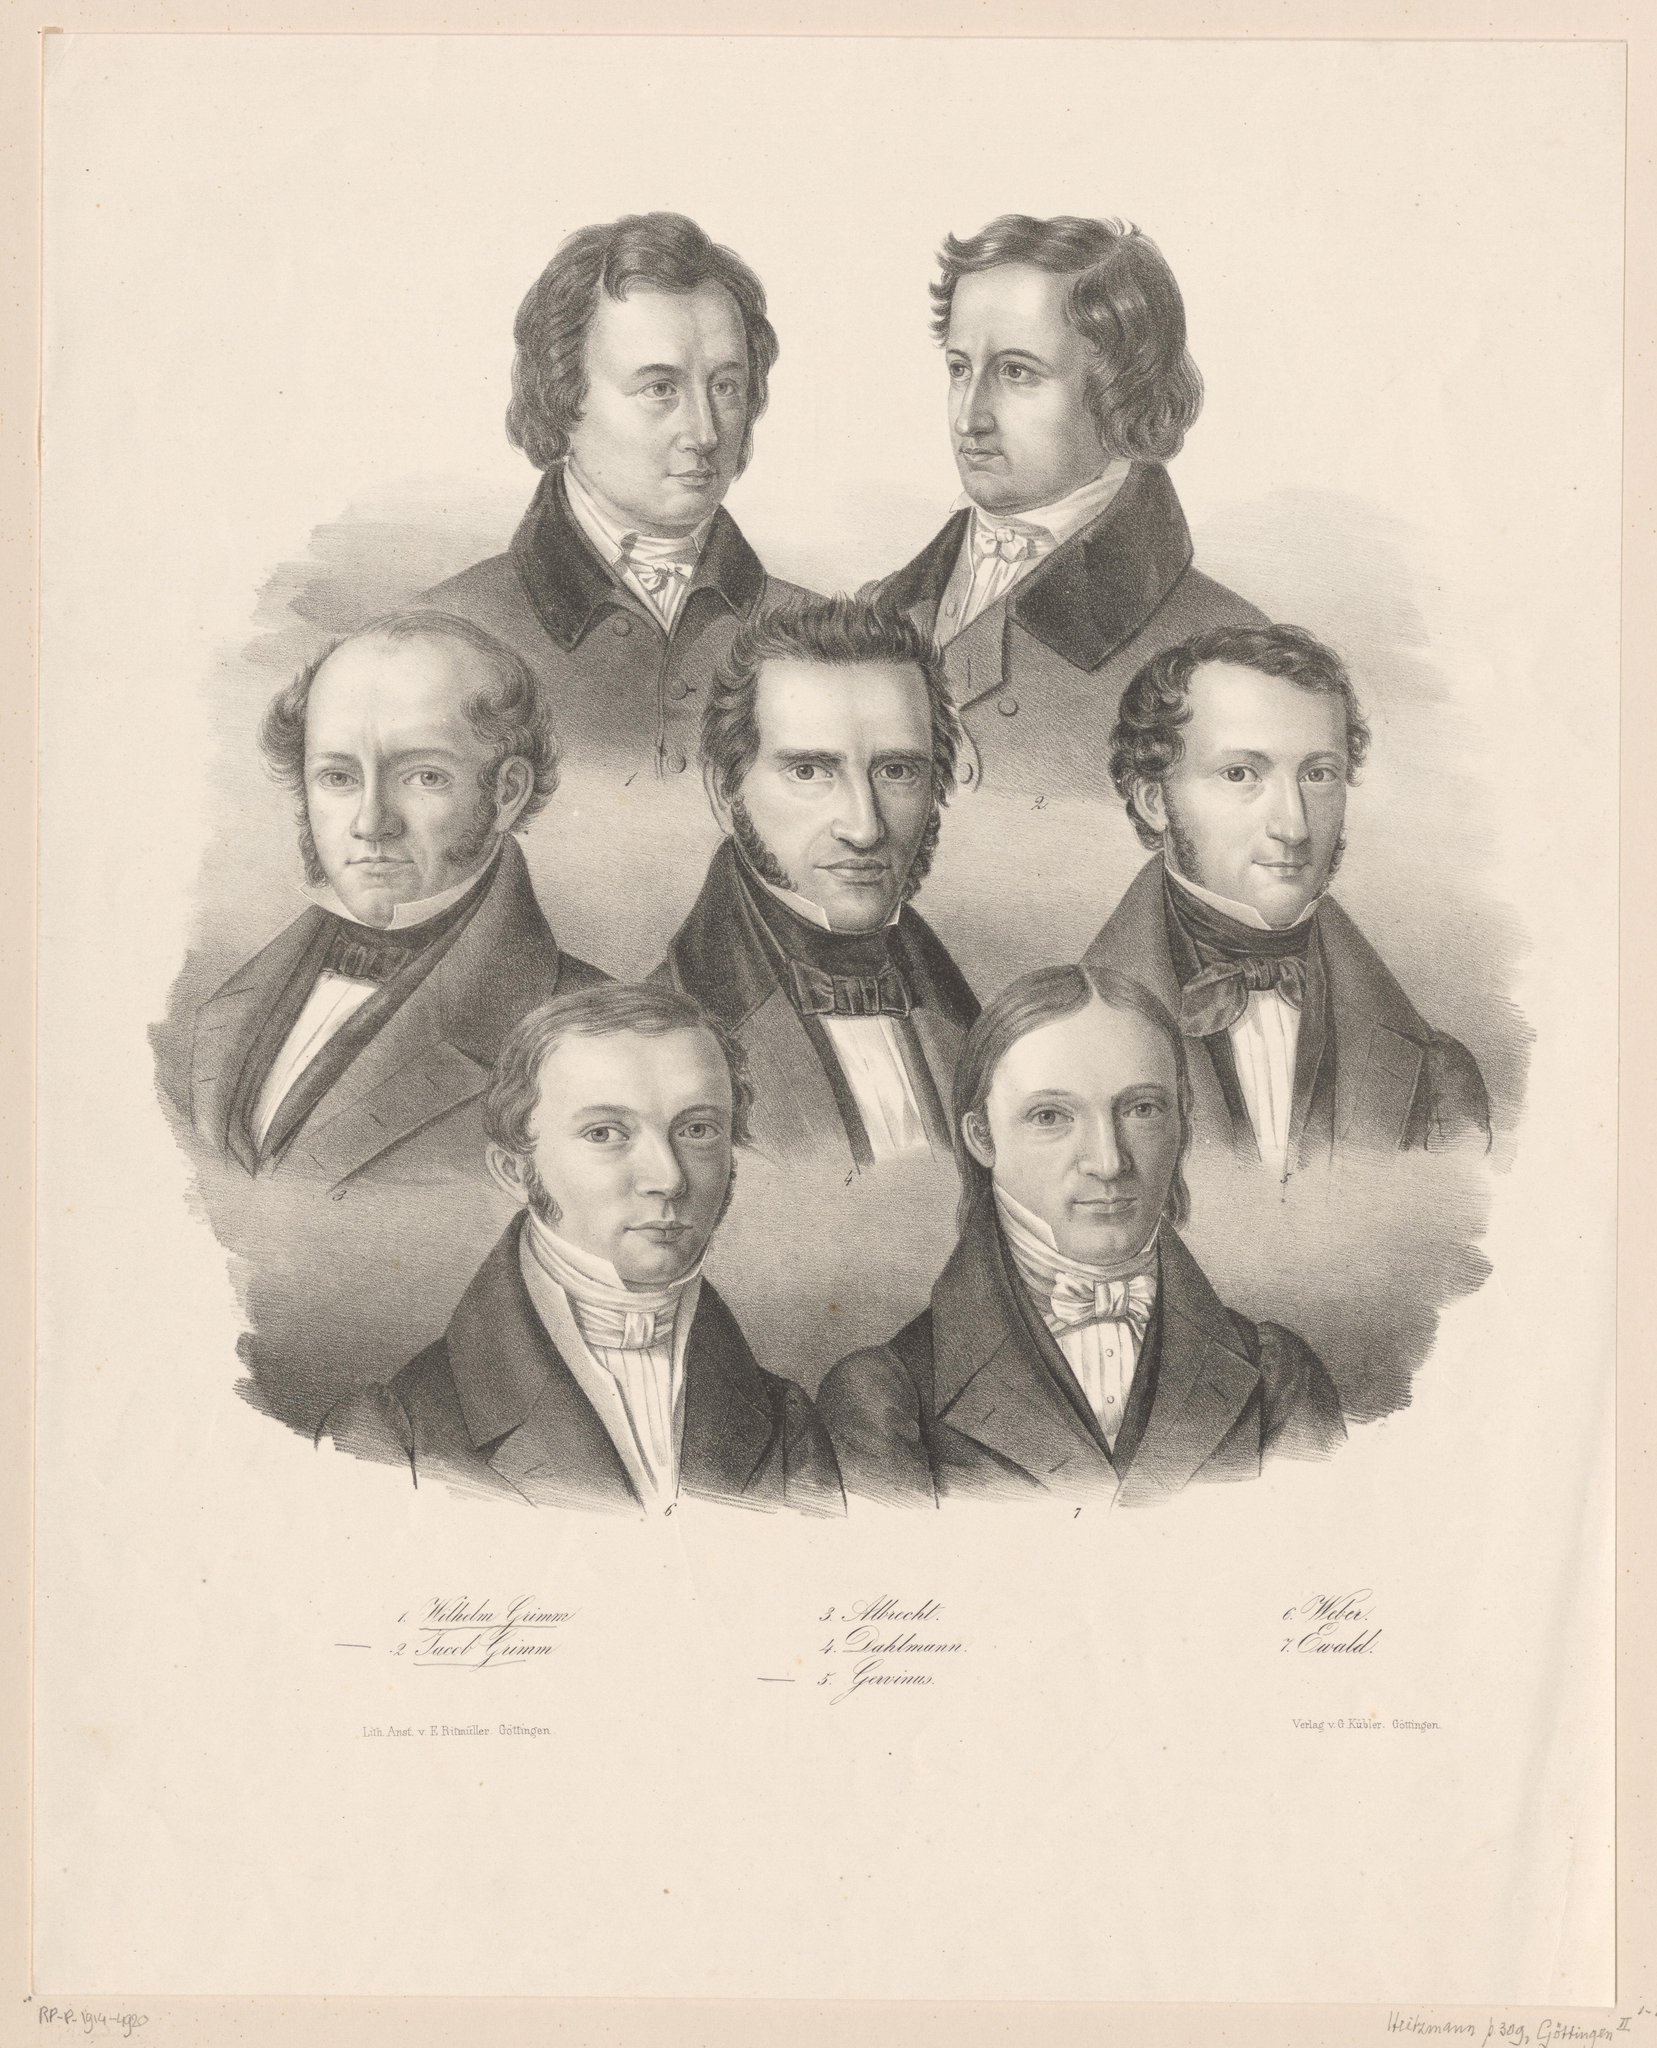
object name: print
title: Portretten van zeven Duitse mannen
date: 1825-1830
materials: paper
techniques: lithograph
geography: gottingen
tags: jacob ludwig karl grimm, politician, physicist, historical persons, politician, e.g. party leader, writer, poet, author, professor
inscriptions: collector's mark: Lugt 2228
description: Portretten van Wilhelm Karl Grimm, Jacob Ludwig Karl Grimm, Wilhelm Eduard Albrecht, Friedrich Christoph Dahlmann, Georg Gottfried Gervinus, Wilhelm Eduard Weber en Heinrich Ewald.